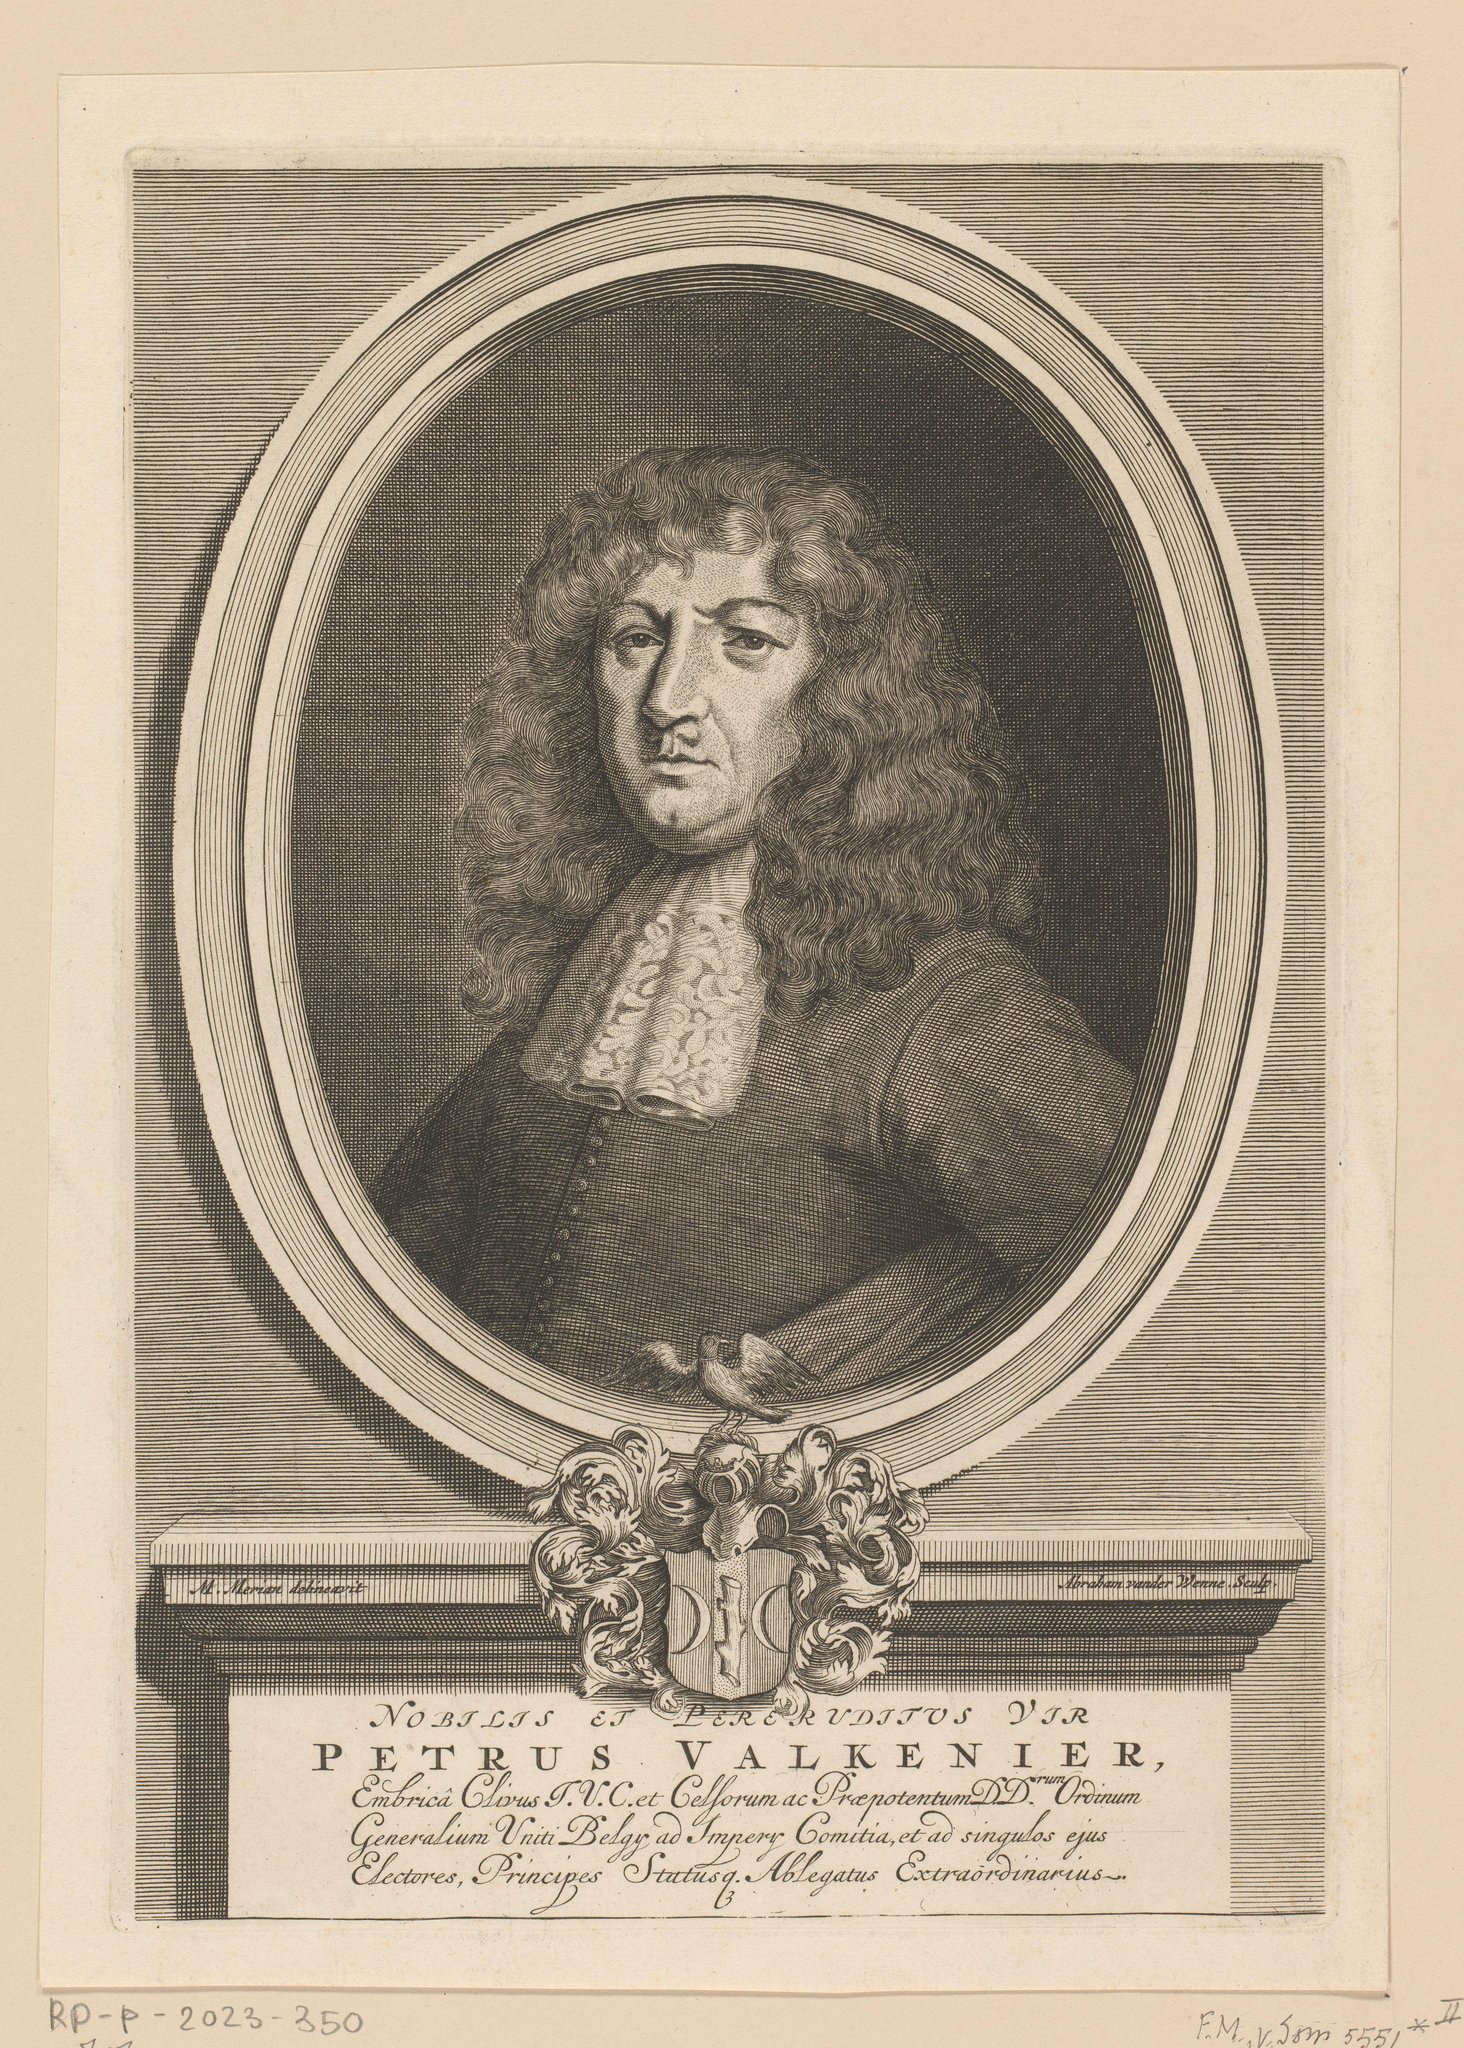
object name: print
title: Portret van Pieter Valckenier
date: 1670-1681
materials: paper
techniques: engraving, etching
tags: history and archaeology, historical persons, lawyer, attorney at law, diplomacy, diplomat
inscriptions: inscription: ‘J [...] D.1. [...] 306’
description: Met drieregelig onderschrift in het Latijn.